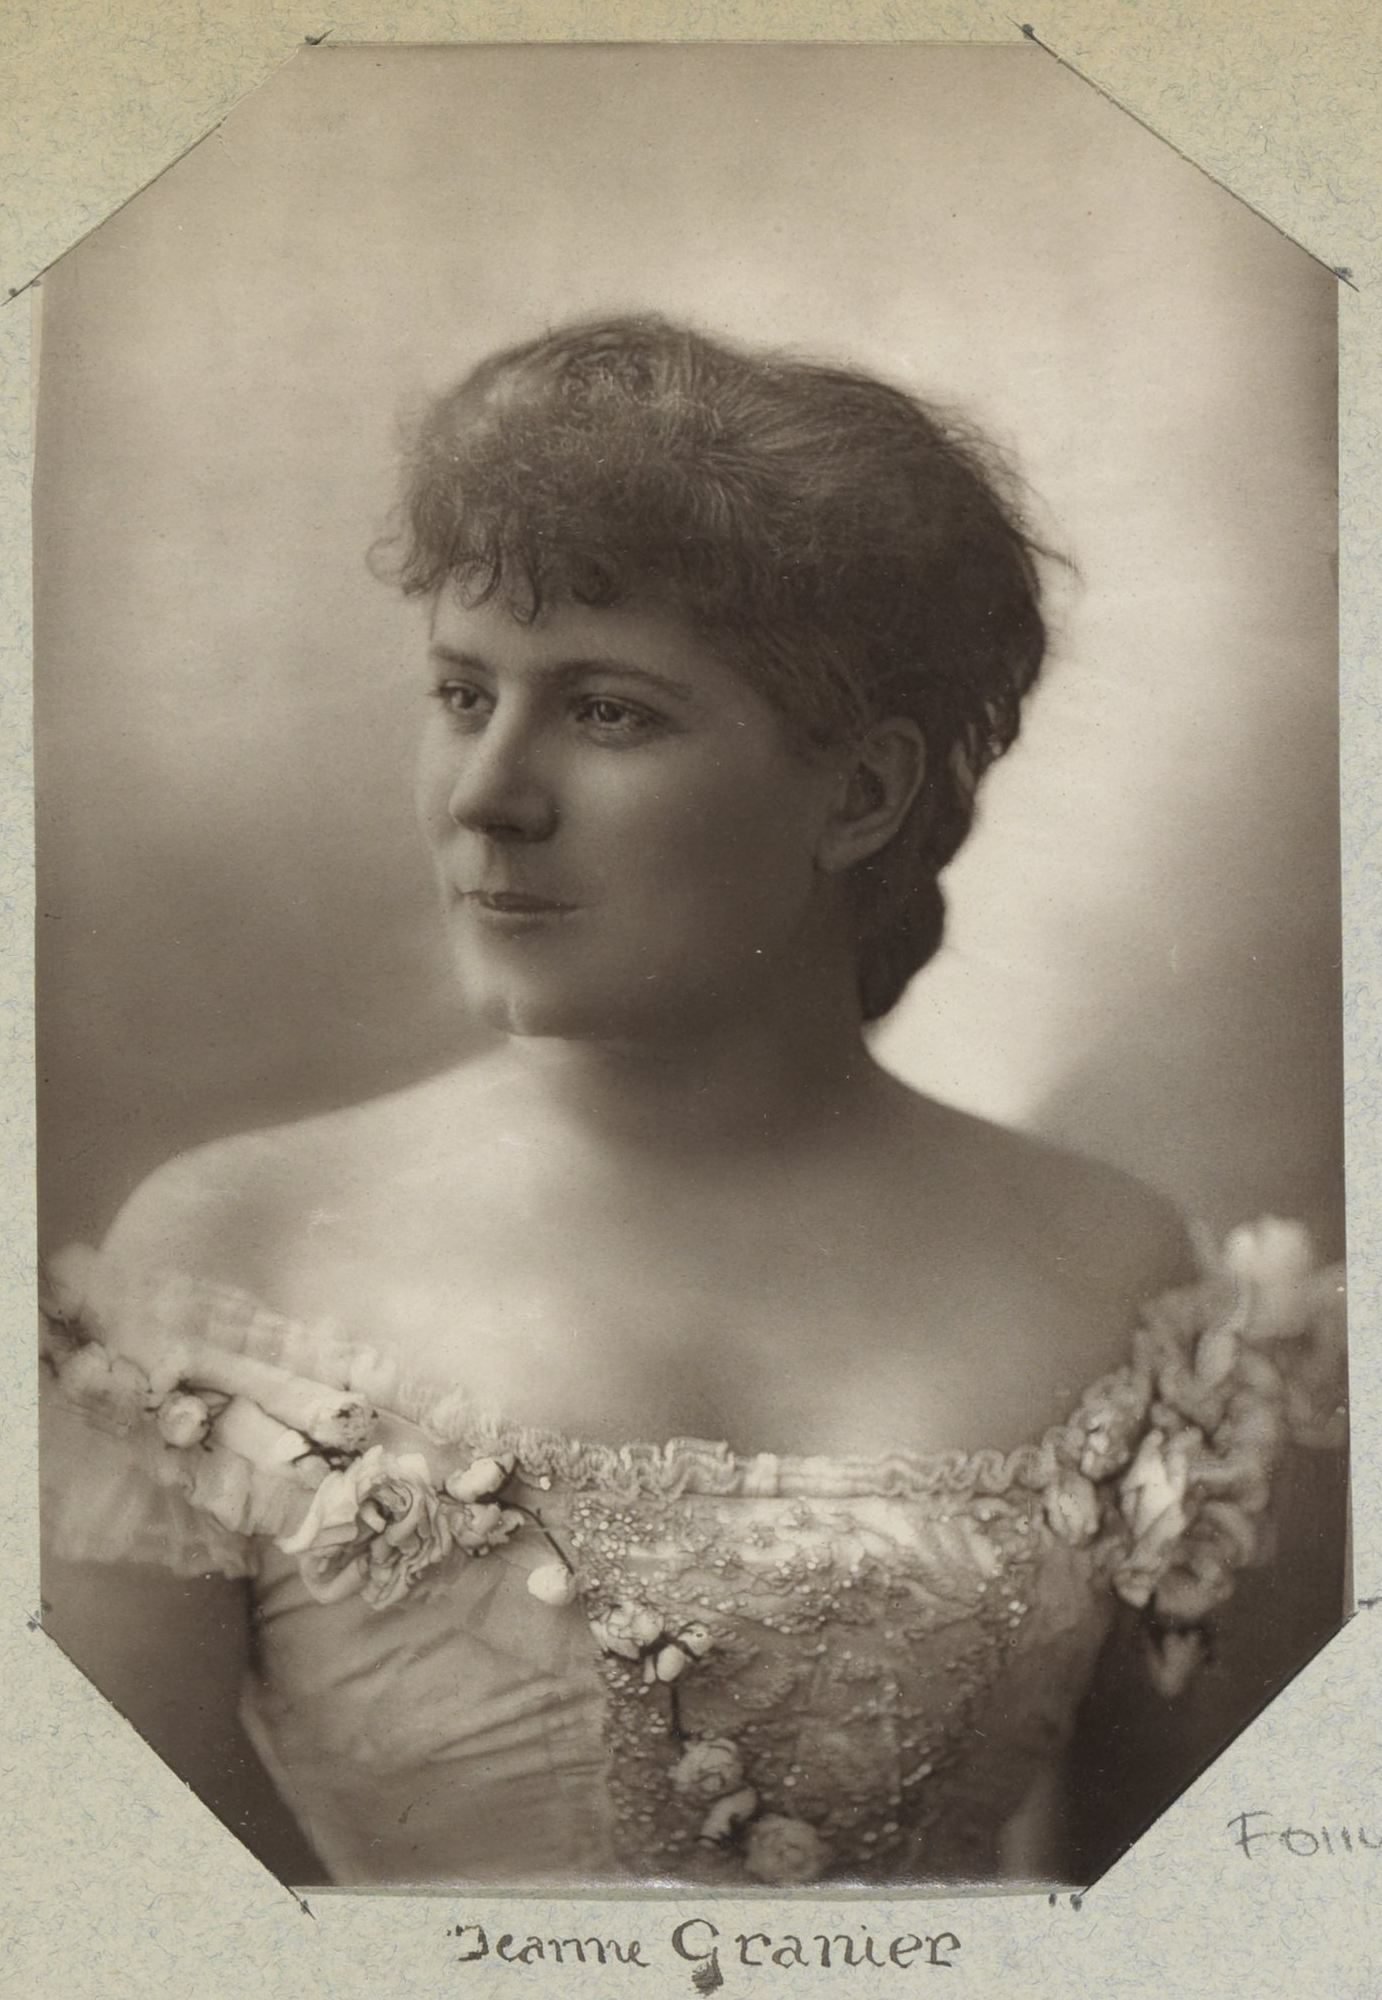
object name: album leaf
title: Portret van Jeanne Granier, zangeres en actrice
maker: Anonymous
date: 1890-1900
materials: paper, photographic support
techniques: carbon print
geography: france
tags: portrait of actor, actress, female singer, france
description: Onderdeel van Album van een Franse amateur met foto's van Frankrijk, Algerije, Palmyra, de Wereldtentoonstelling van 1900 en van bekende Fransen.